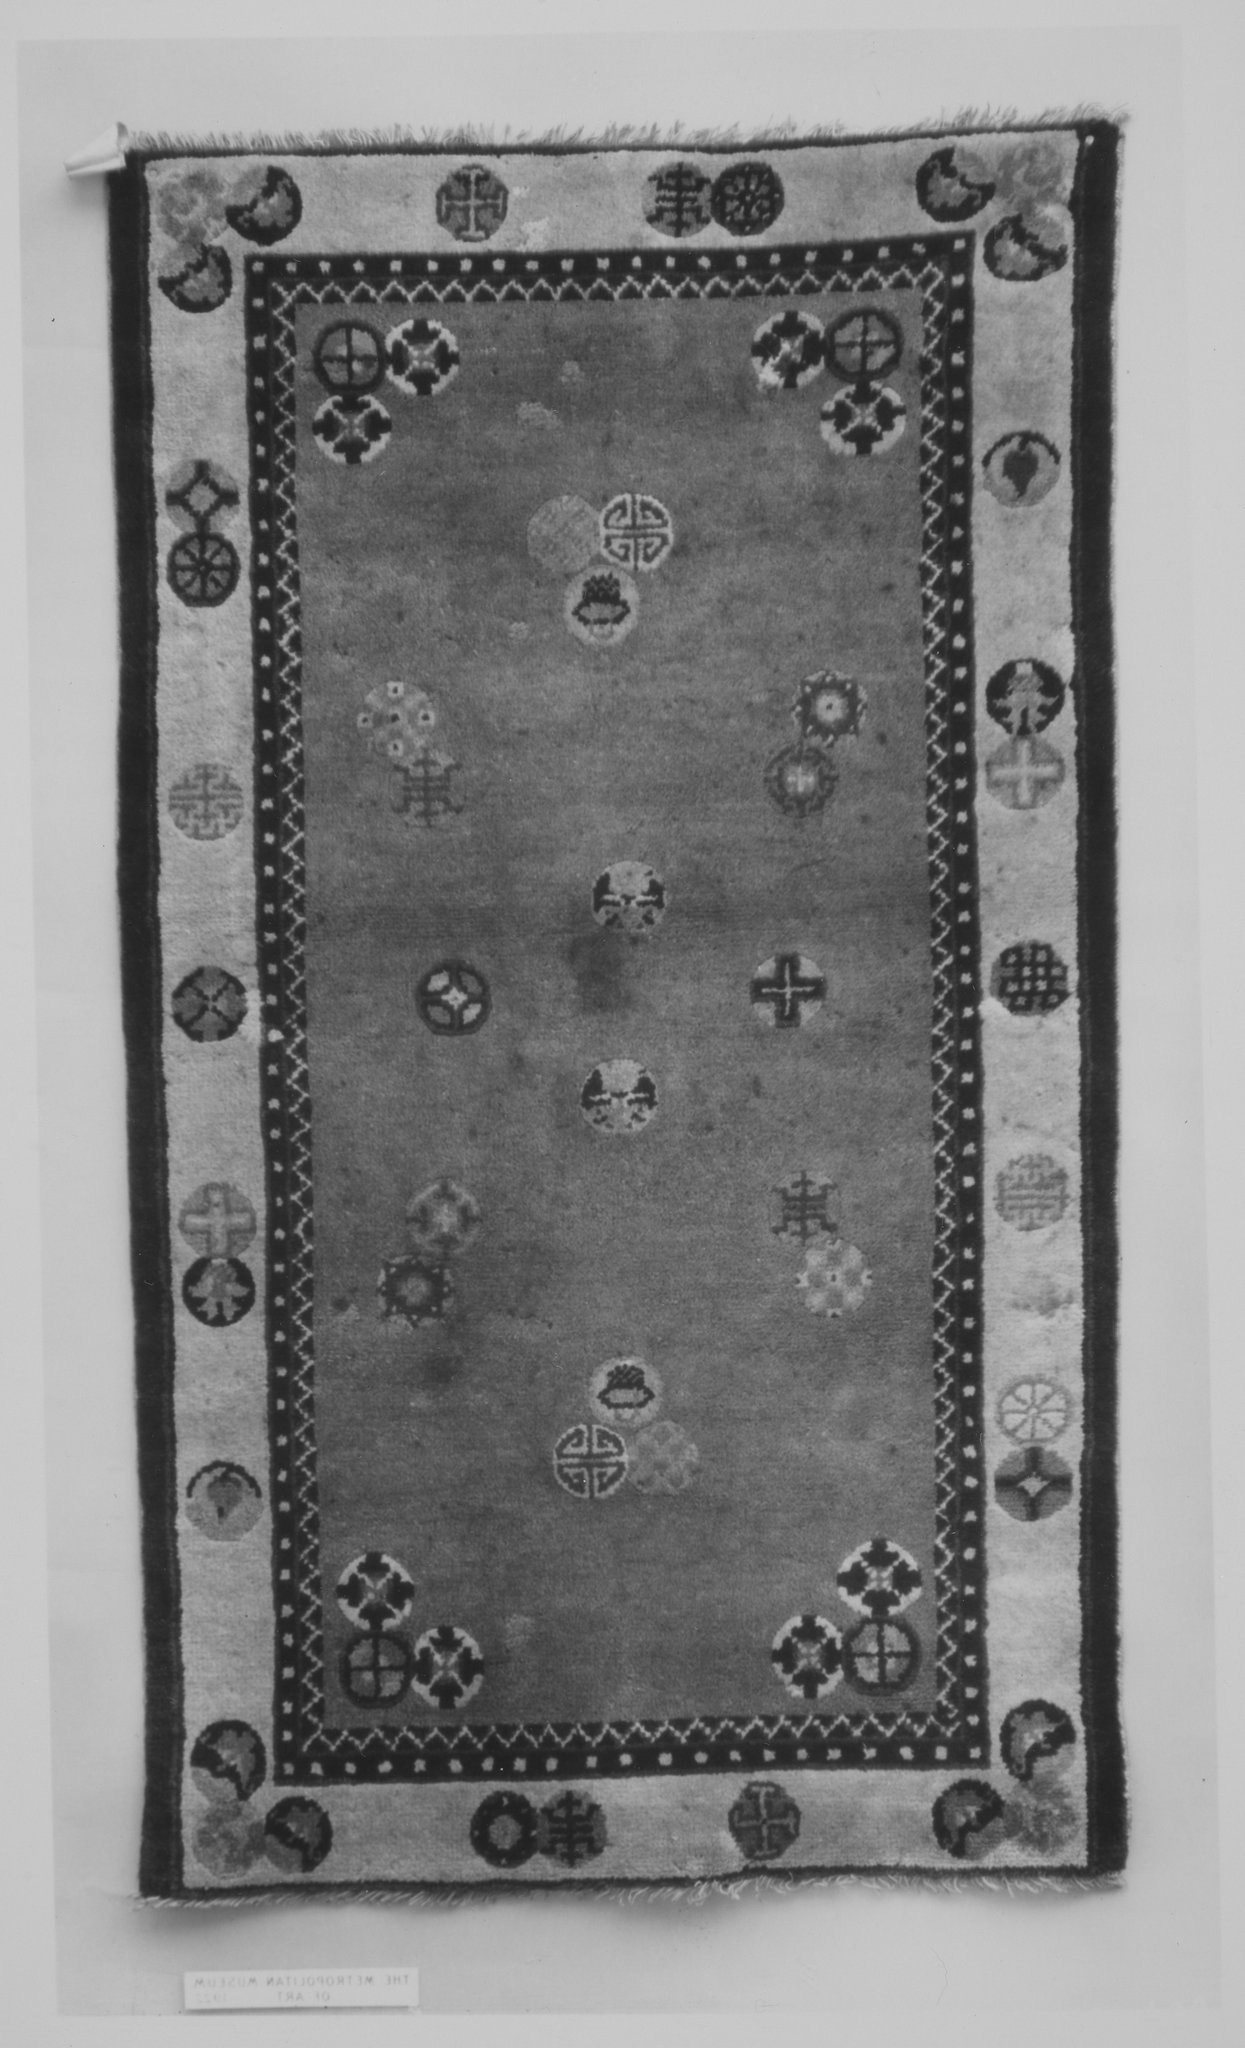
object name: rug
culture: chinese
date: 1867-1900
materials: cotton, wool